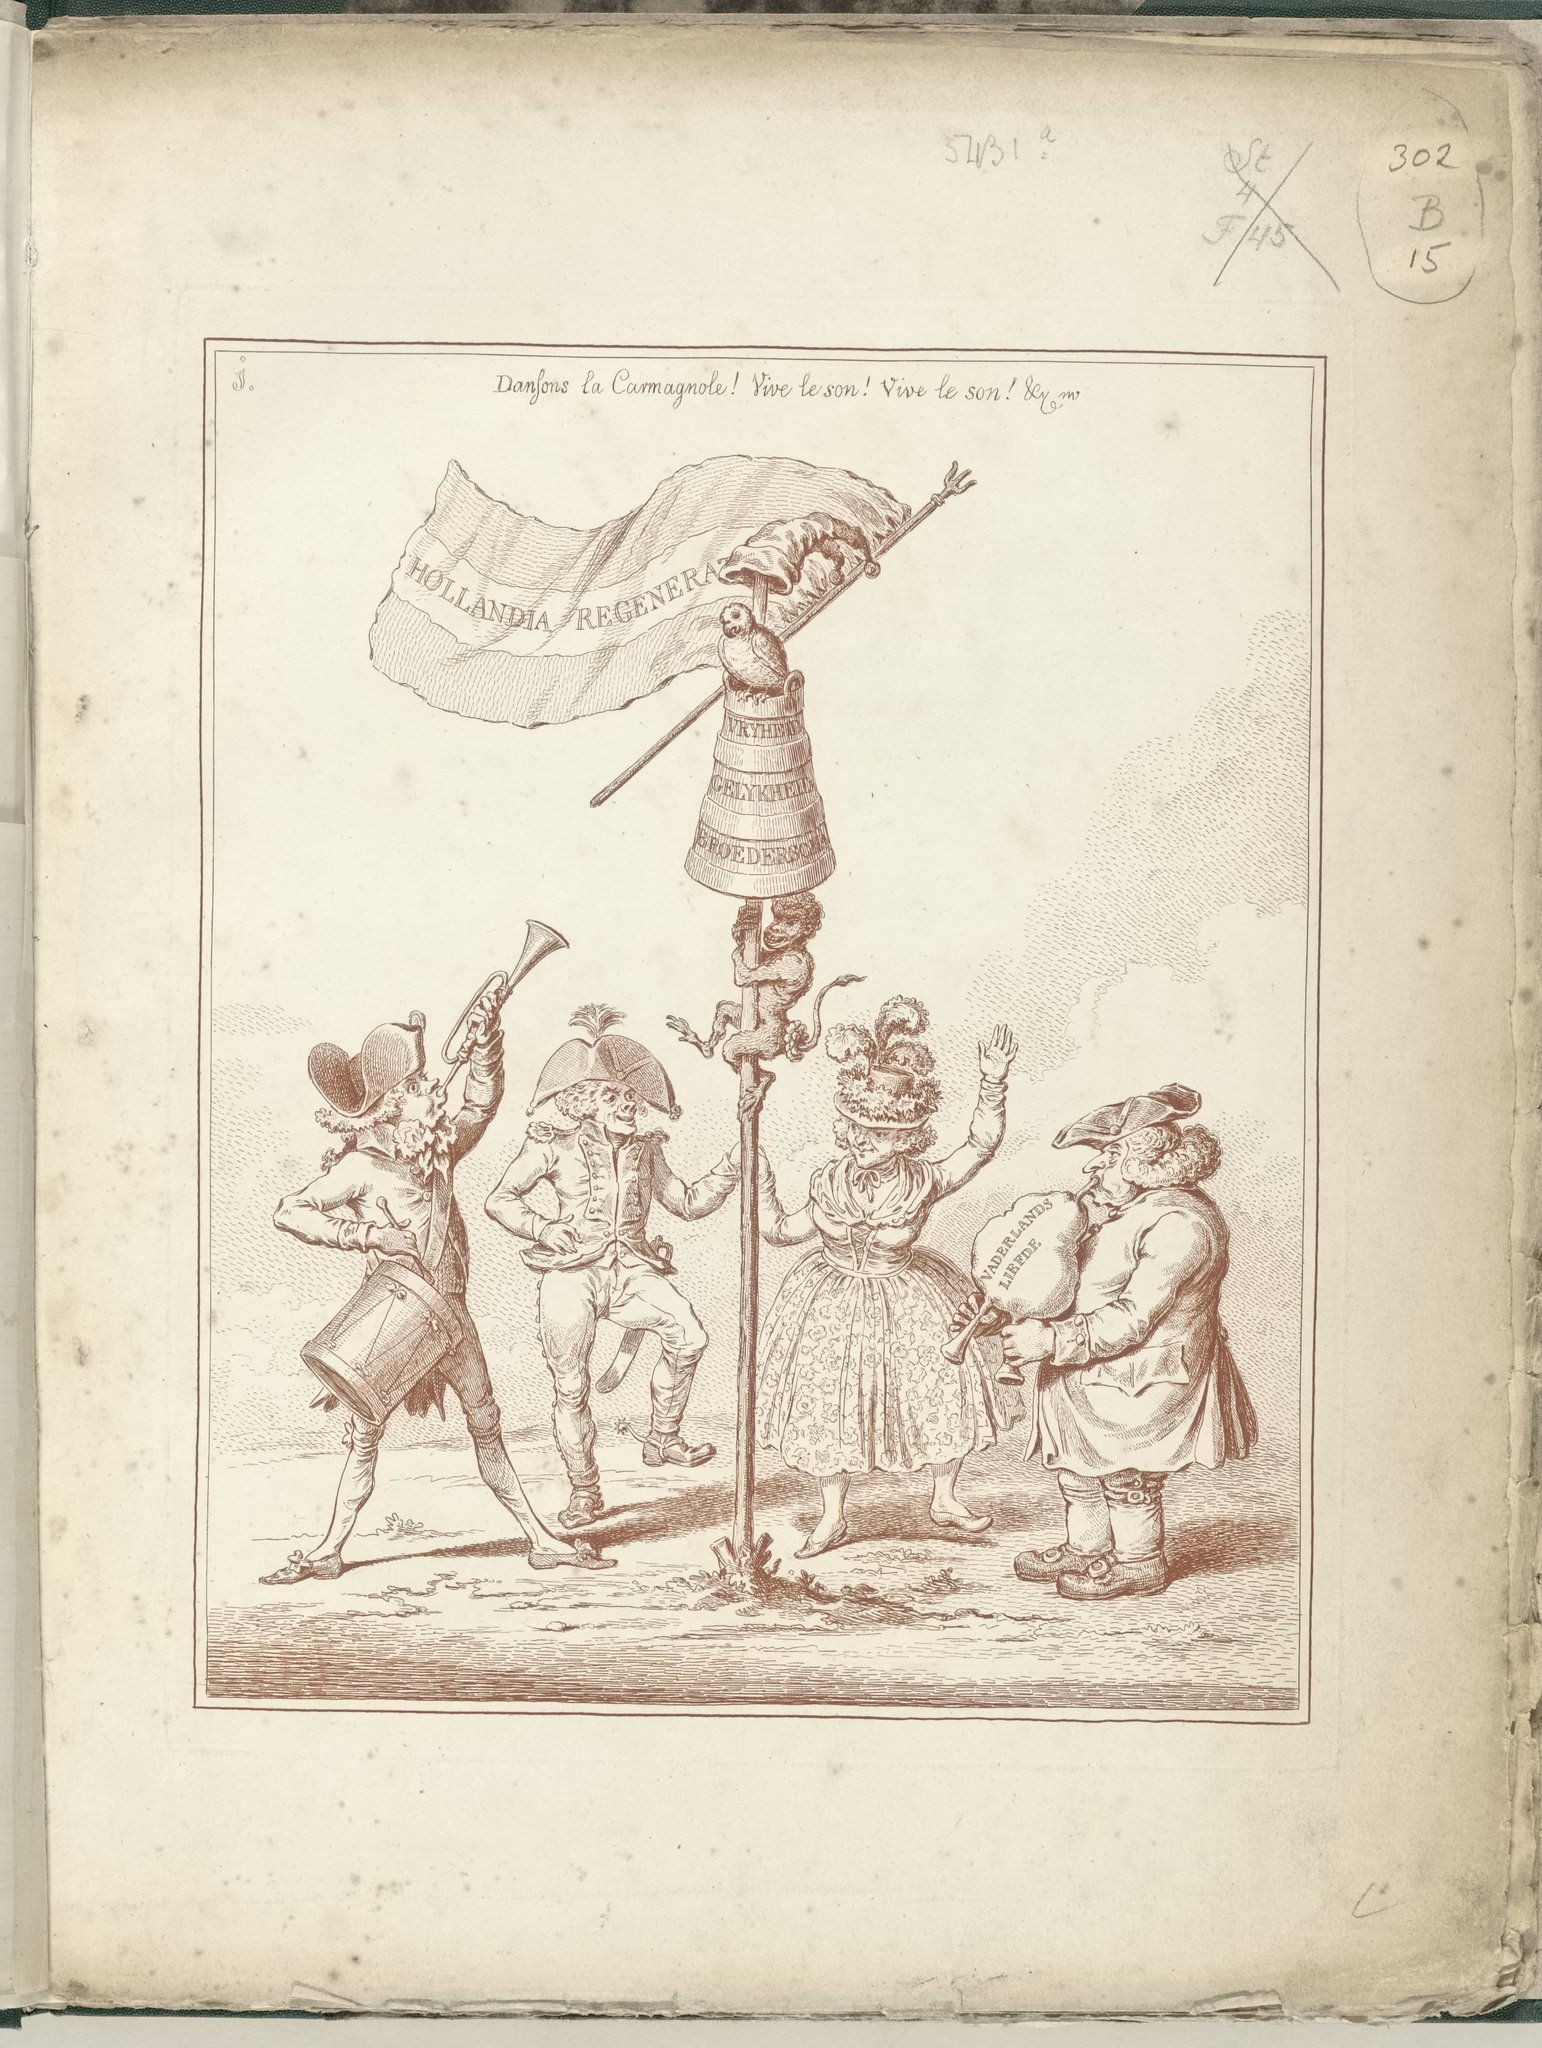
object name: cartoon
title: Hollandia Regenerata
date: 1795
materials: paper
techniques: etching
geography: london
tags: monkeys, apes, ornamental birds: parrot, dancing around the tree of liberty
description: Onderdeel van een in boekvorm uitgegeven serie van twintig spotprenten op de Provisionele Representanten van het Volk van Holland en de Bataafse Republiek in het algemeen in het jaar 1795. De serietitel 'Hollandia Regenerata' staat vermeld op de titelprent. Elke prent gevolgd door een tekstblad met een Bijbelcitaat in het Nederlands, een verklaring in het Frans en het Bijbelcitaat in het Engels. Waarschijnlijk uitgegeven in Londen door William Humphrey in 1795.